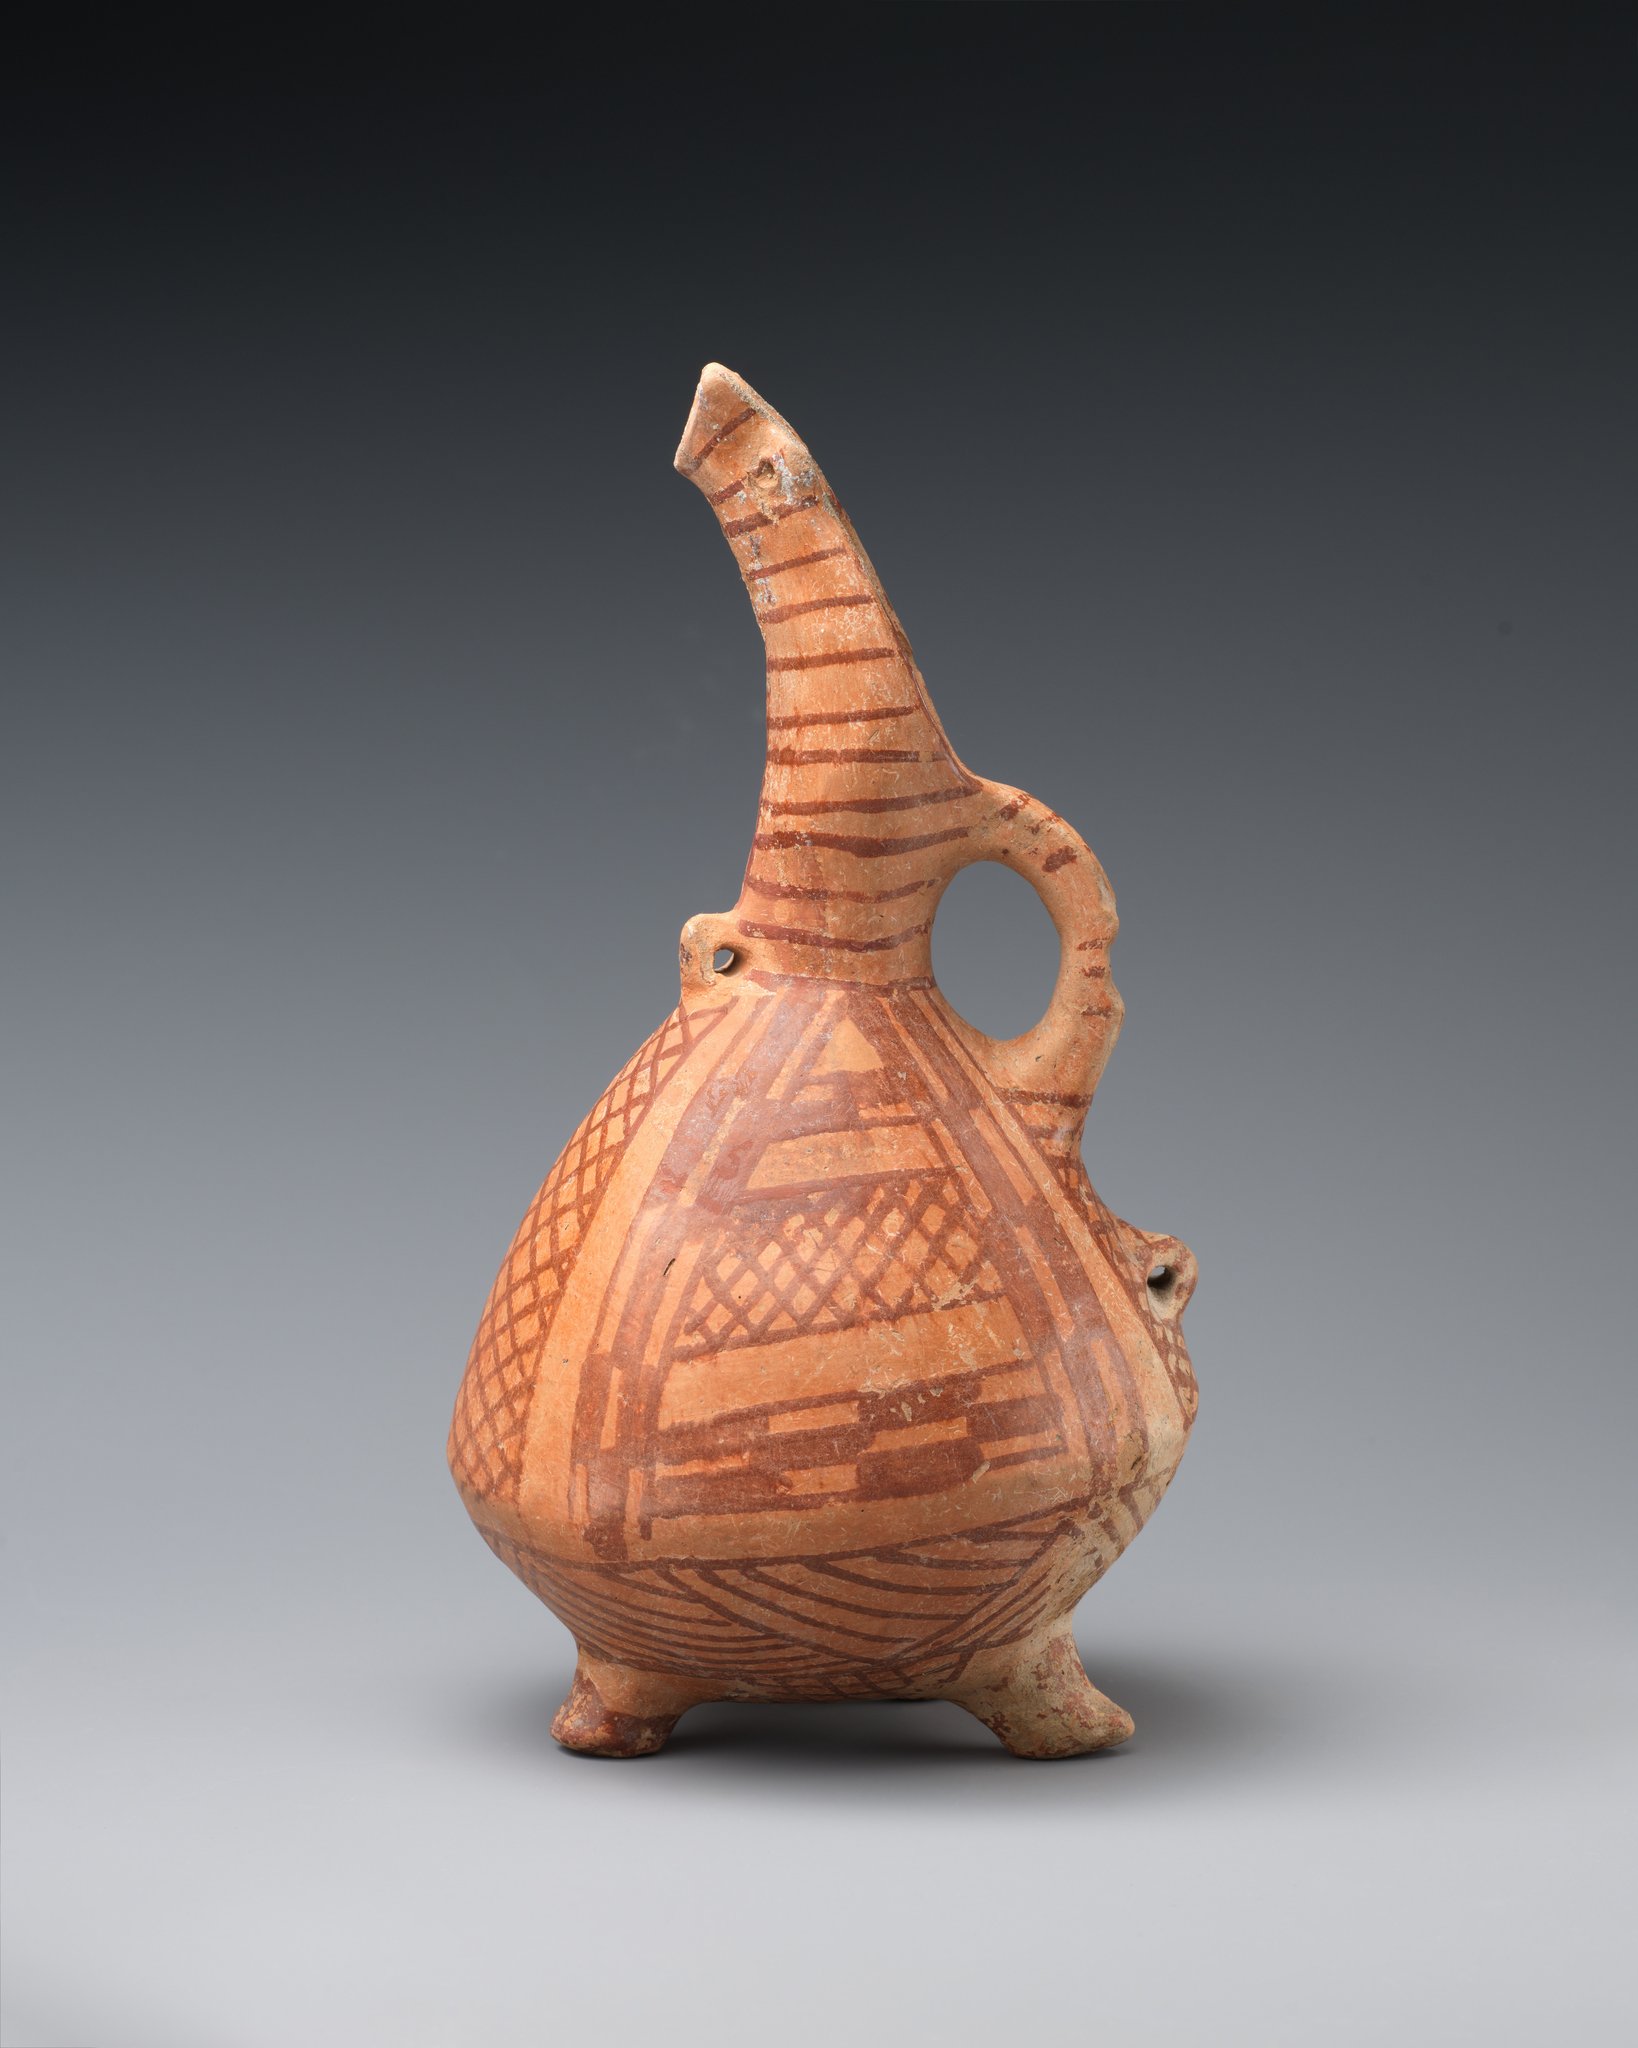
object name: jug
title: Terracotta jug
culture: cypriot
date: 1900-1800 BCE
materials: terracotta